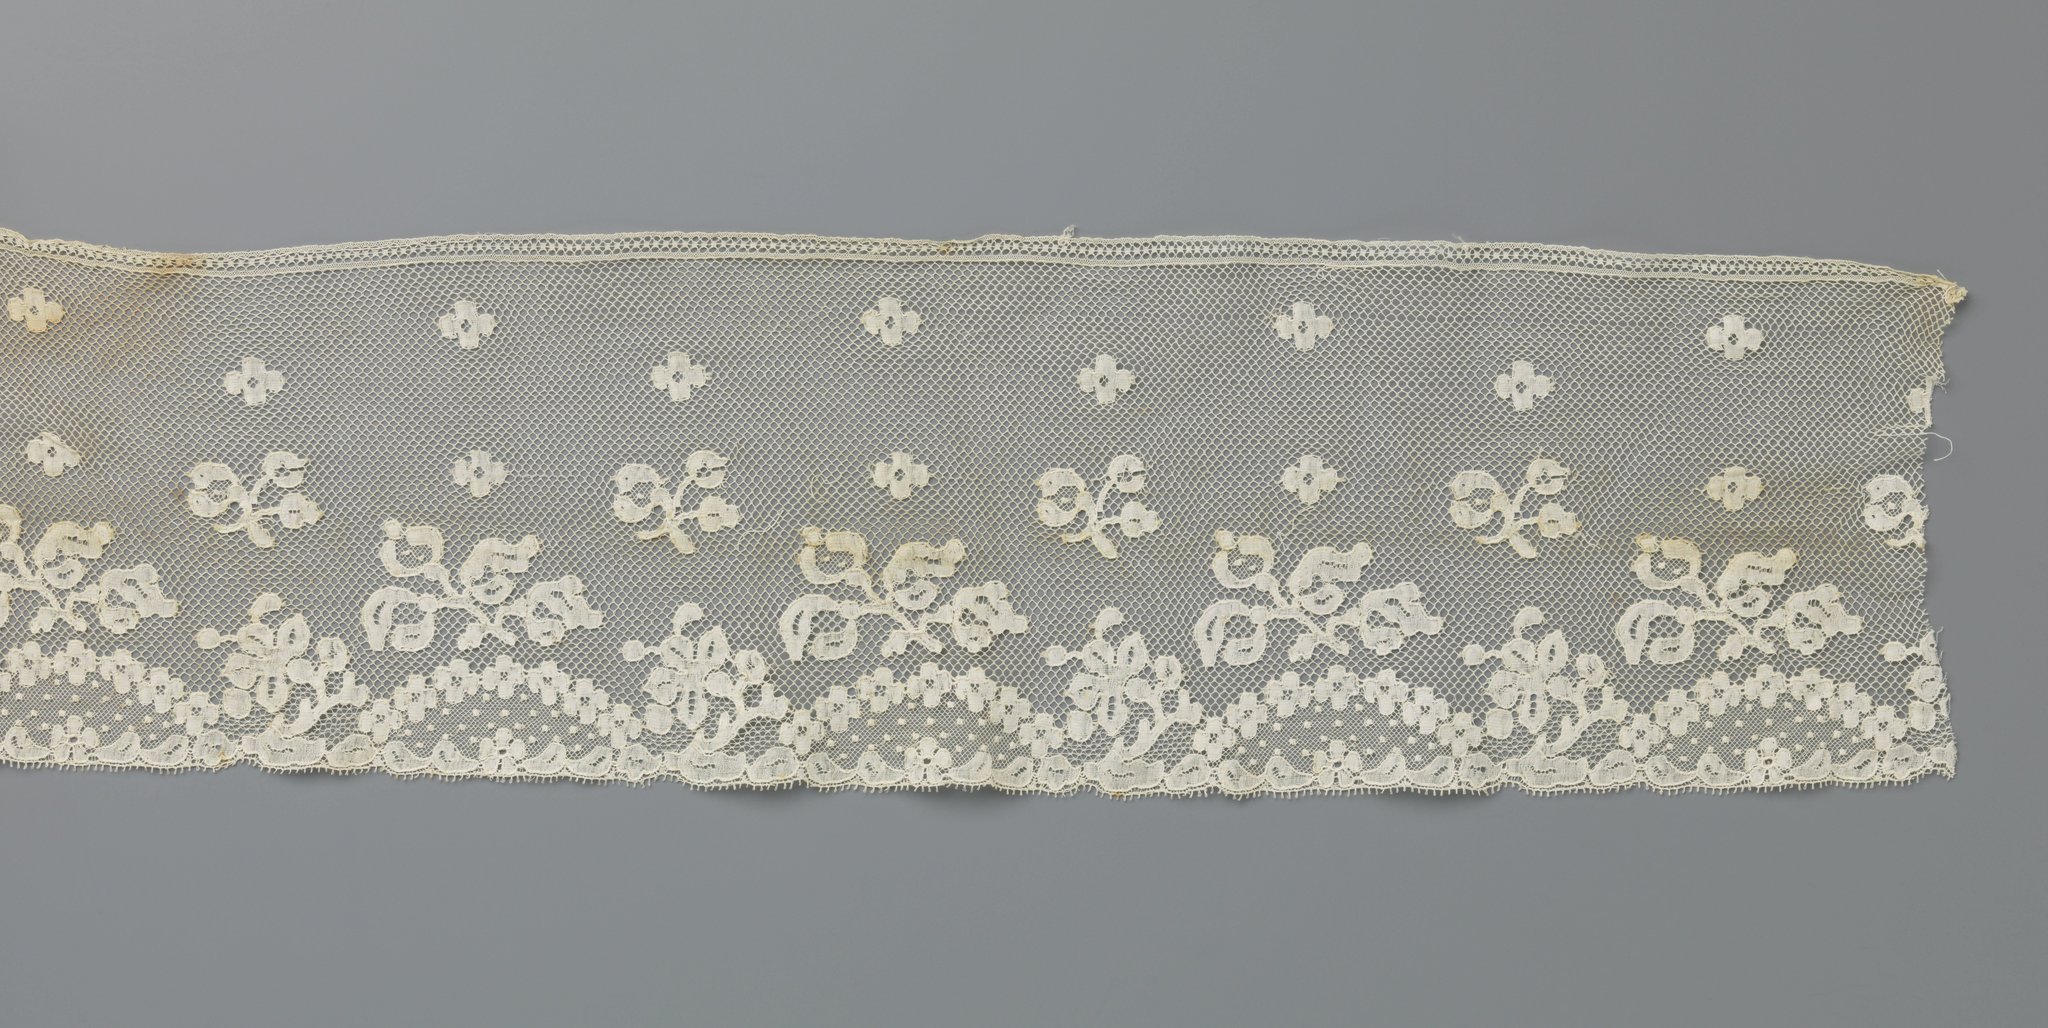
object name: strip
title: Strook machinale kant met schuingeplaatste en diep ingesneden zevenlobbige bloemen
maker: Anonymous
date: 1800-1949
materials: cotton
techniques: lace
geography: western europe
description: Strook naturelkleurige machinale kant. De strook bestaat uit twee aan elkaar genaaide delen, met een zeer duidelijke grove naad. Het zich herhalende patroon bestaat van boven naar onder uit: twee rijen wijd verspreide rozetbloemen; drie rijen bloemtakken en langs de onderzijde regelmatige boogjes van zeven rozetbloempjes. In het veldje onder elk boogje een fijne traliegrond met moesjes, die langs de rechte onderzijde van de strook wordt afgesloten door een rij blaadjes met één rozetbloempje in het midden, recht onder het boogje. Een smal randje langs de bovenzijde van de strook heeft het patroon van een sierrand met een rij sneeuwvlokken. De motieven zijn gemaakt in linnenslag en voorzien van contourdraden. De motieven zijn met elkaar verbonden door een ruitvormige traliegrond. In en om de motieven zijn verschillende machinale siergronden toegepast. De rechte onderzijde van de strook is afgewerkt met picots.